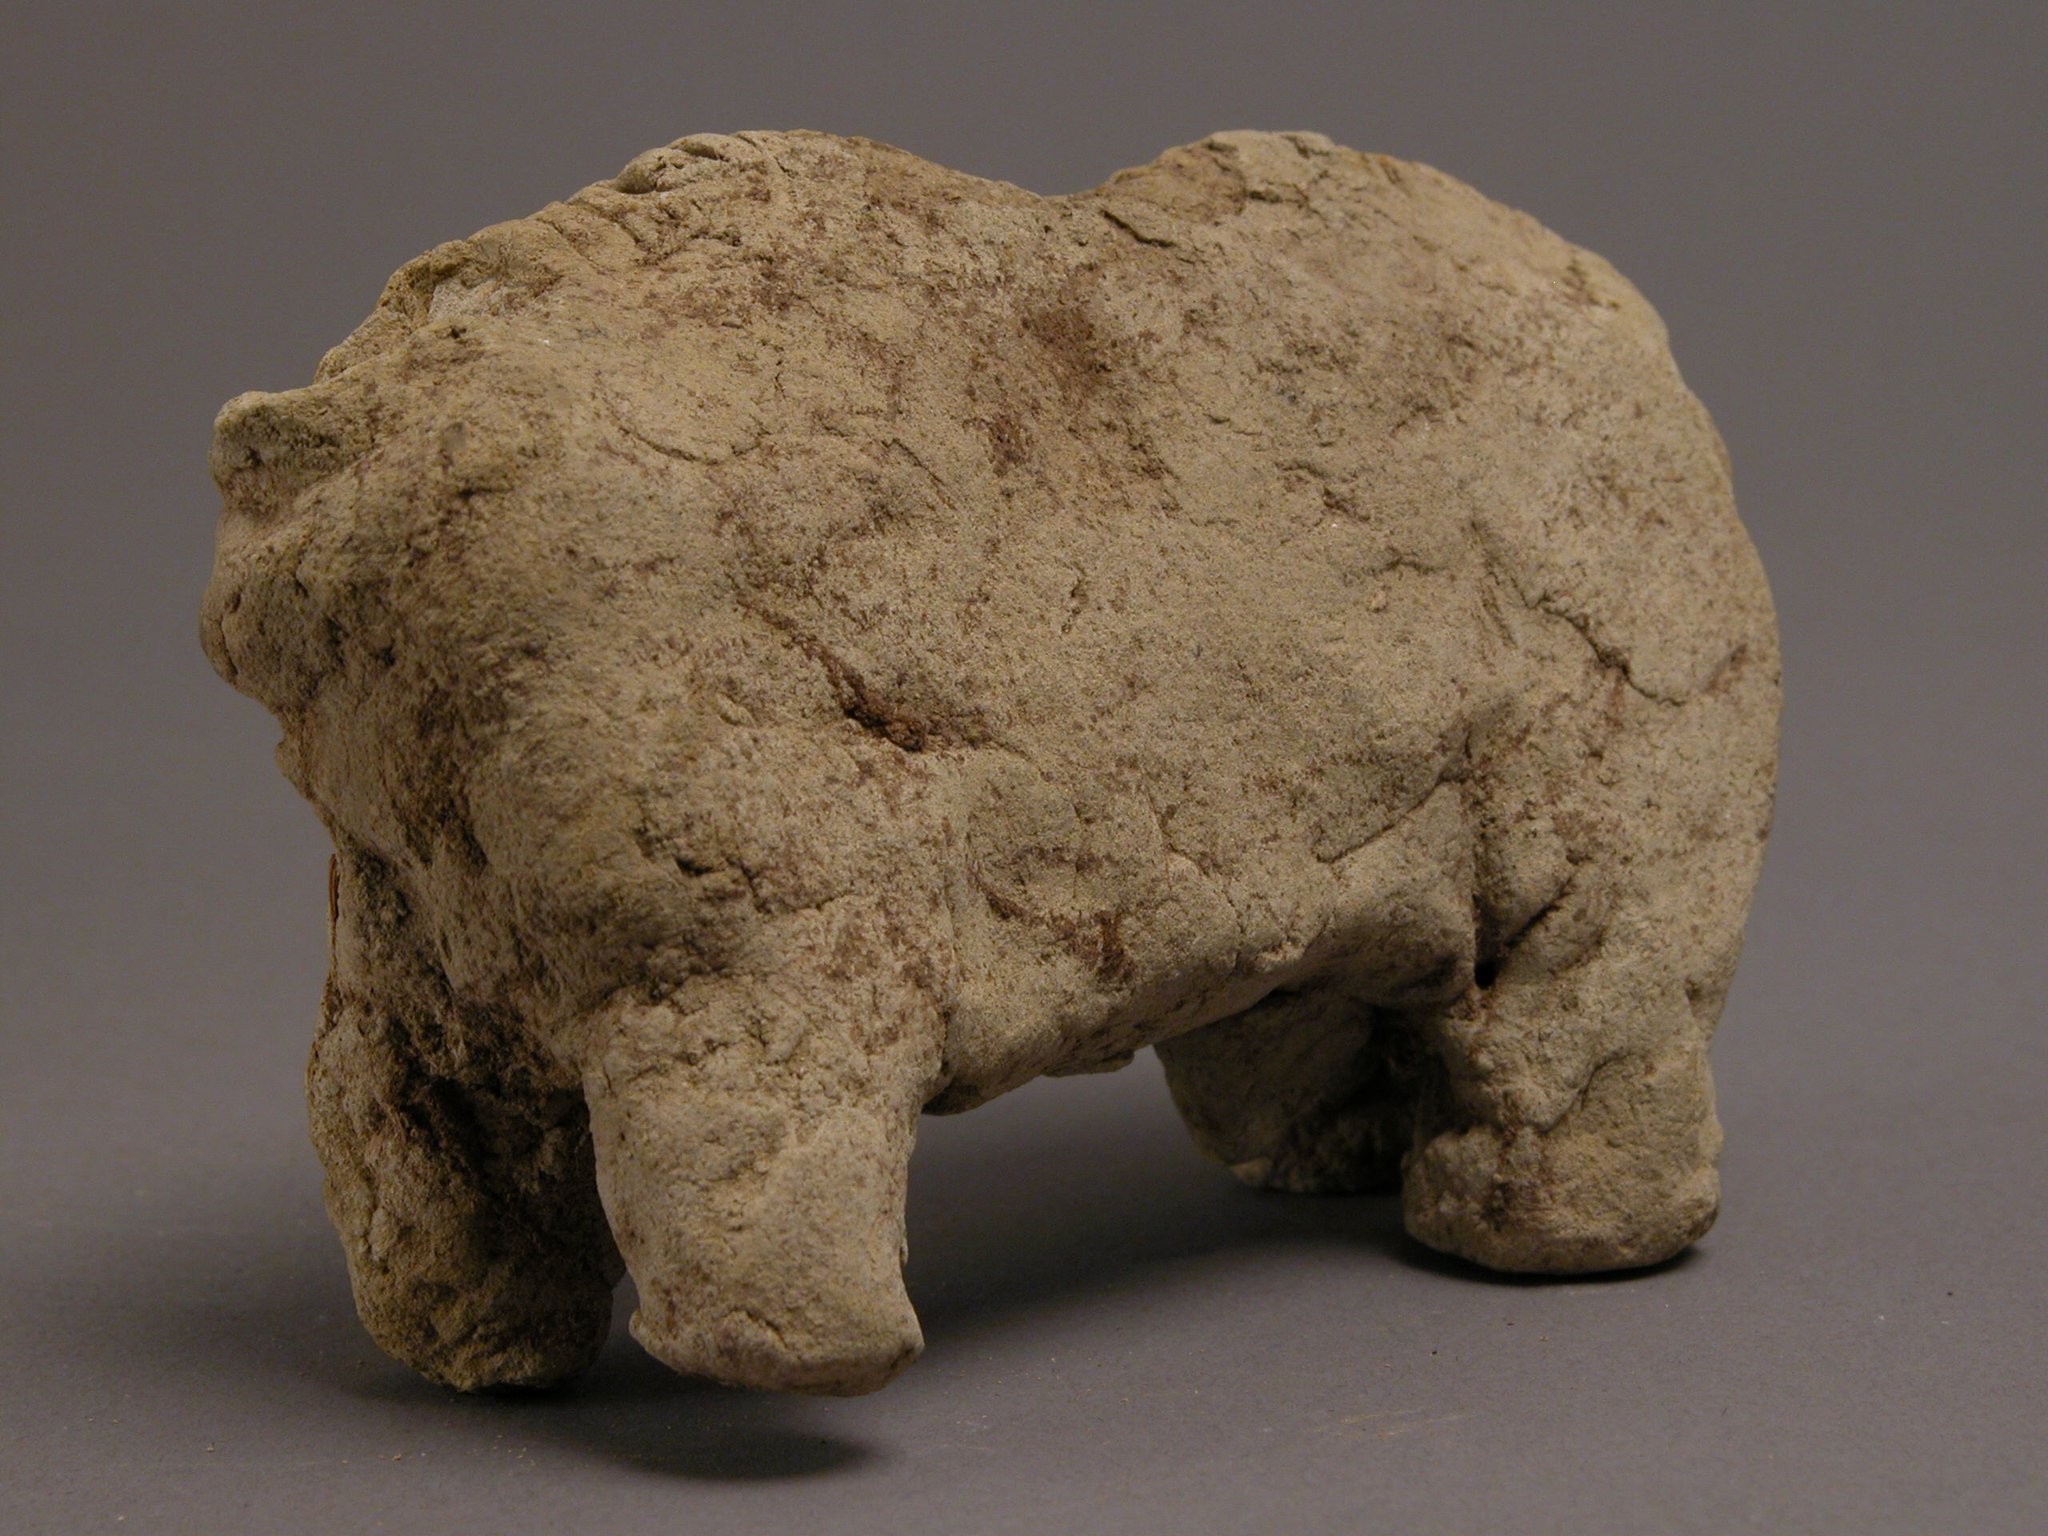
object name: statuette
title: Fragment of an Animal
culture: coptic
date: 301-700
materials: earthenware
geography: egypt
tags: animals